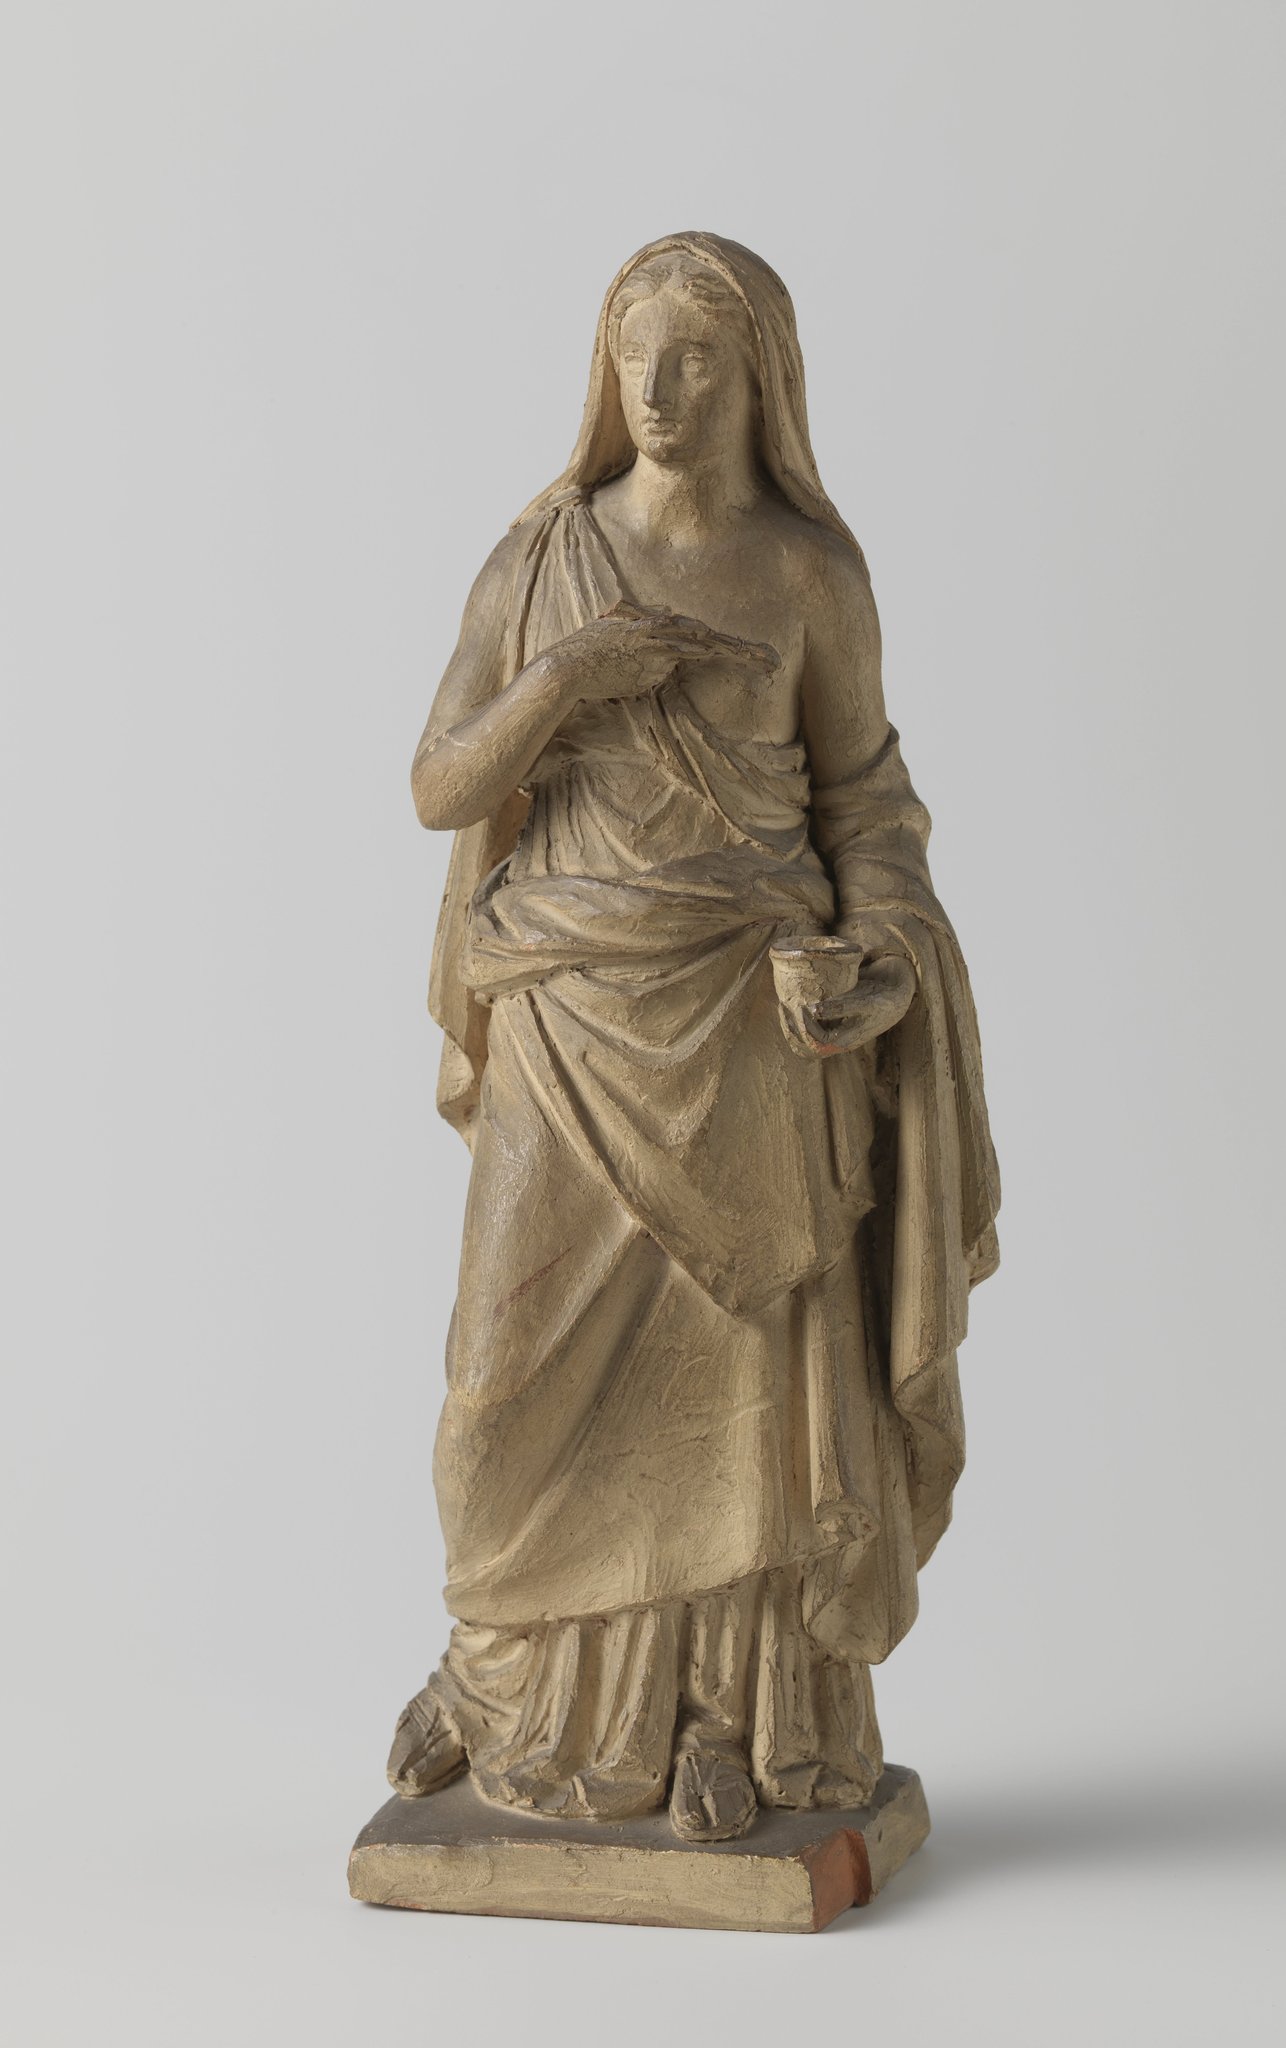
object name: sculpture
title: Symbolisch vrouwenfiguur: Pictura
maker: louis royer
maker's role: draughtsman, sculptor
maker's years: 1793-1868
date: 1803-1868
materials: terracotta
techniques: molding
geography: netherlands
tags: 'pictura', symbolic representations, allegories and emblems ~ painting; 'pittura' (ripa)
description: Pictura staat op een vierkante plint op het linkerbeen en met het gebogen rechter iets terzijde. In de linkerhand draagt zij een verfpotje, in de rechter een penseel voor de borst. Een sluier valt tot over de rug. Zij draagt een lang hemd, dat linker schouder en borst onbedekt laat, en een om het middel geslagen mantel.